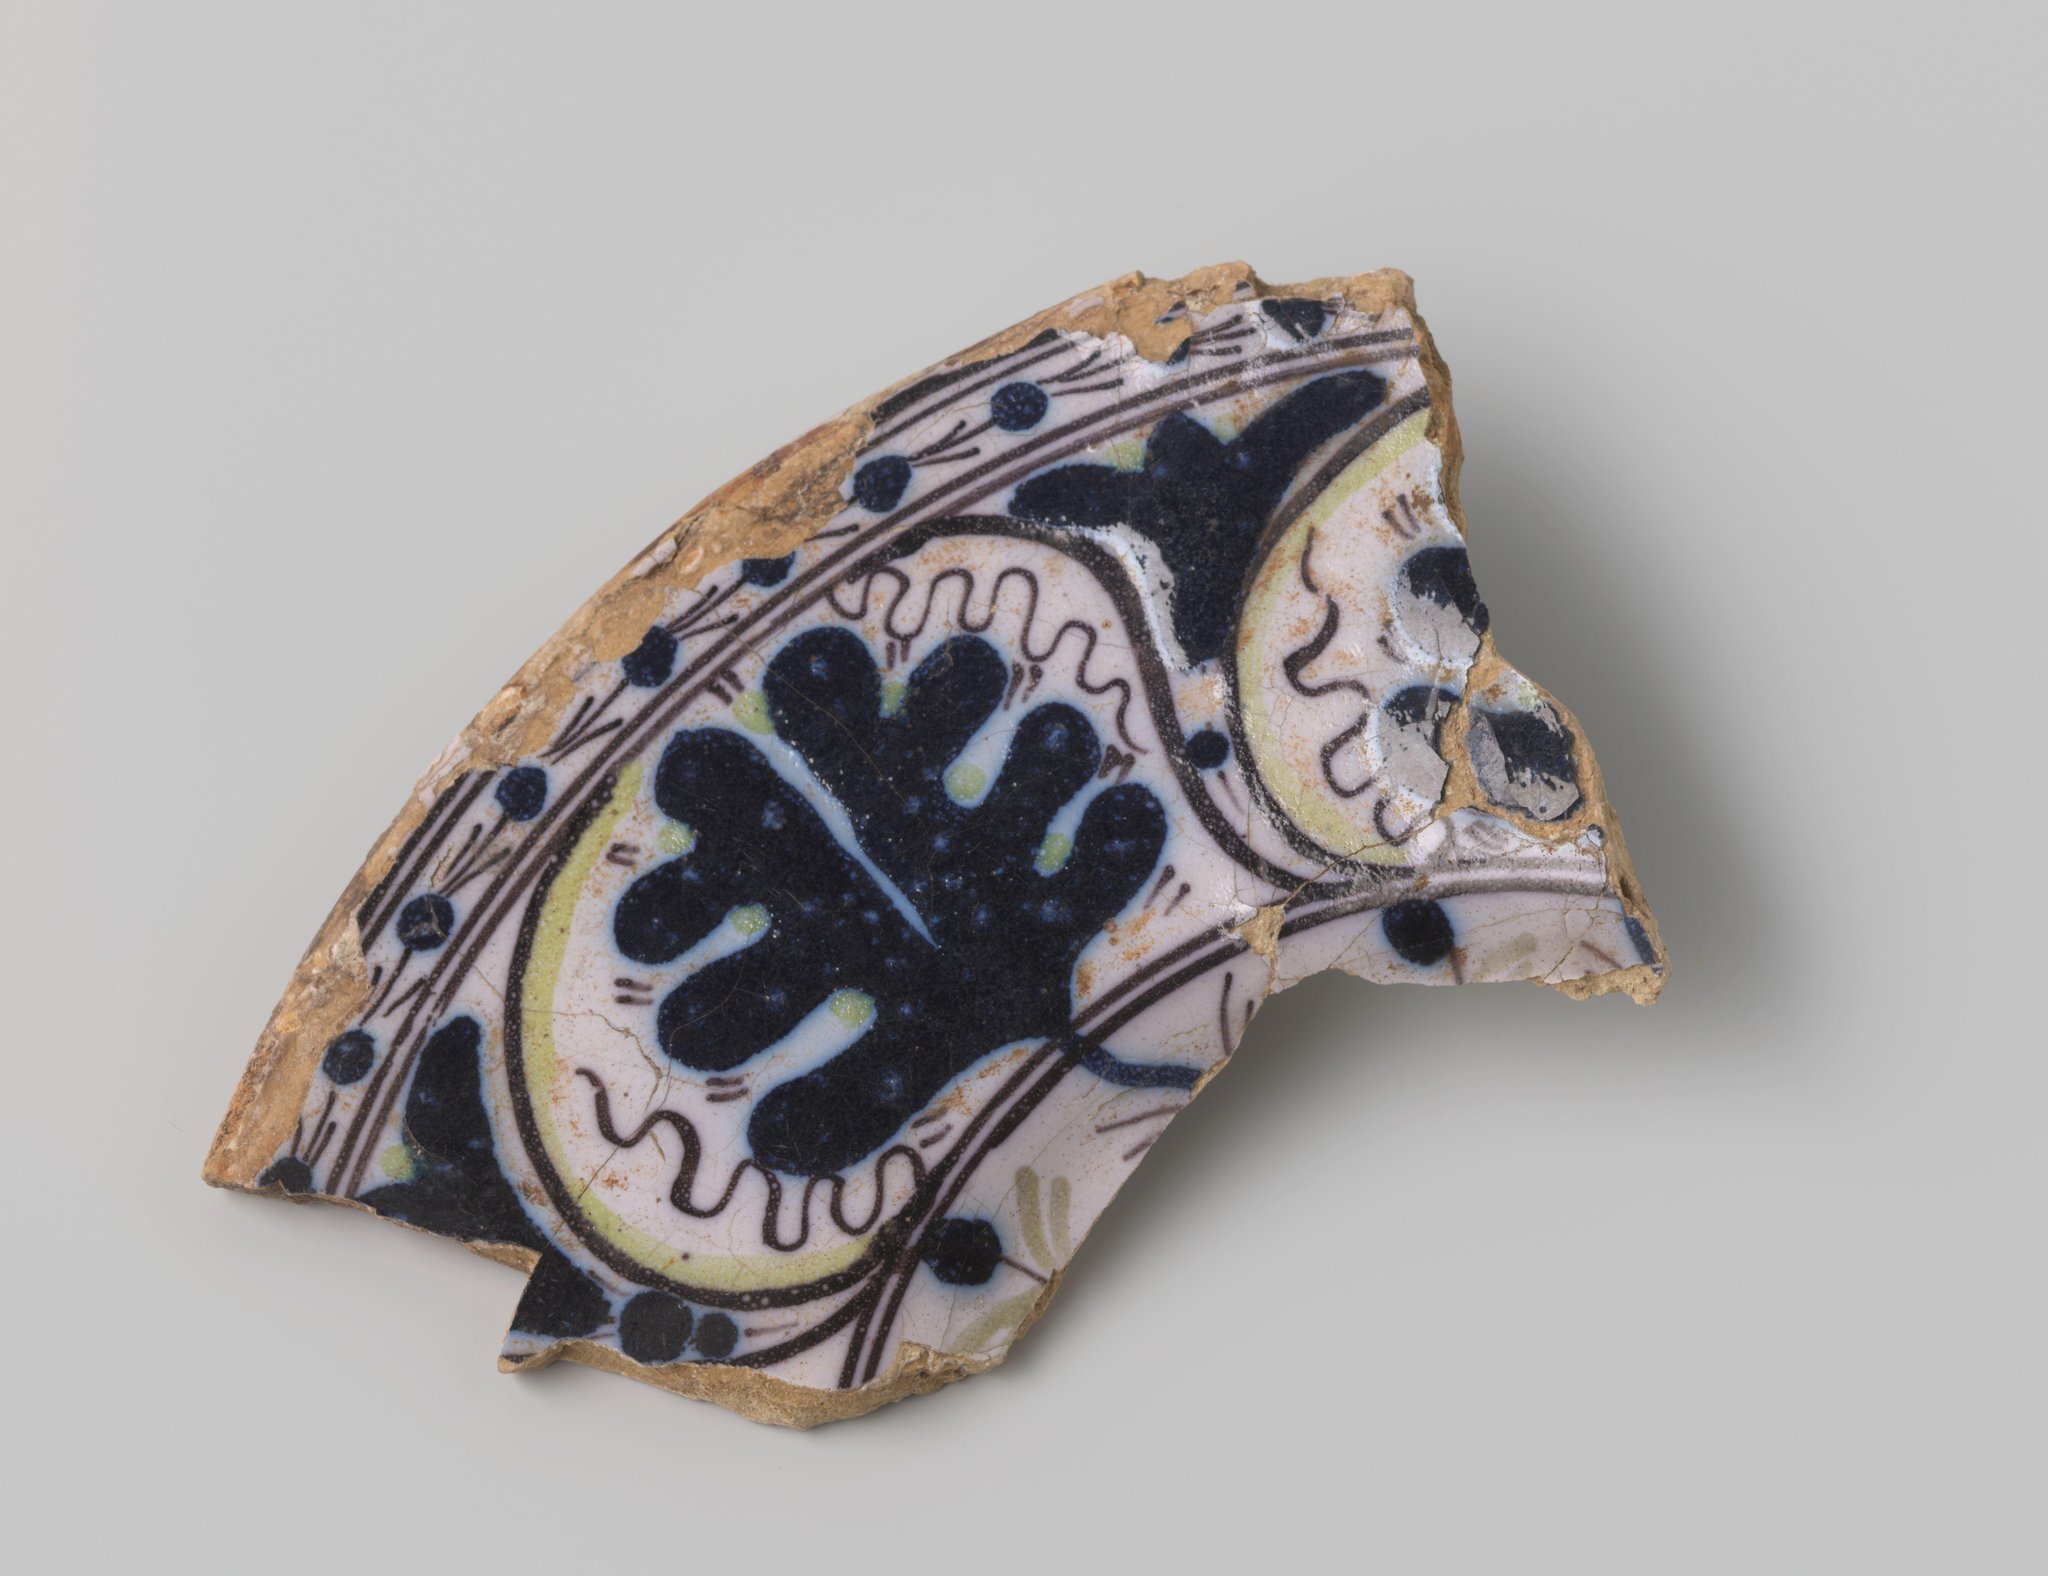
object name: sherd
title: Fragment van een schotel met geelbakkende scherf, met aan de voor- en achterzijde voorzien van lichtroze glazuur, waarop aan de voorzijde in purper, donkerblauw en geel glazuur florale vormen zijn geschilderd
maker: Anonymous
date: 1200-1899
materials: earthenware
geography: italy